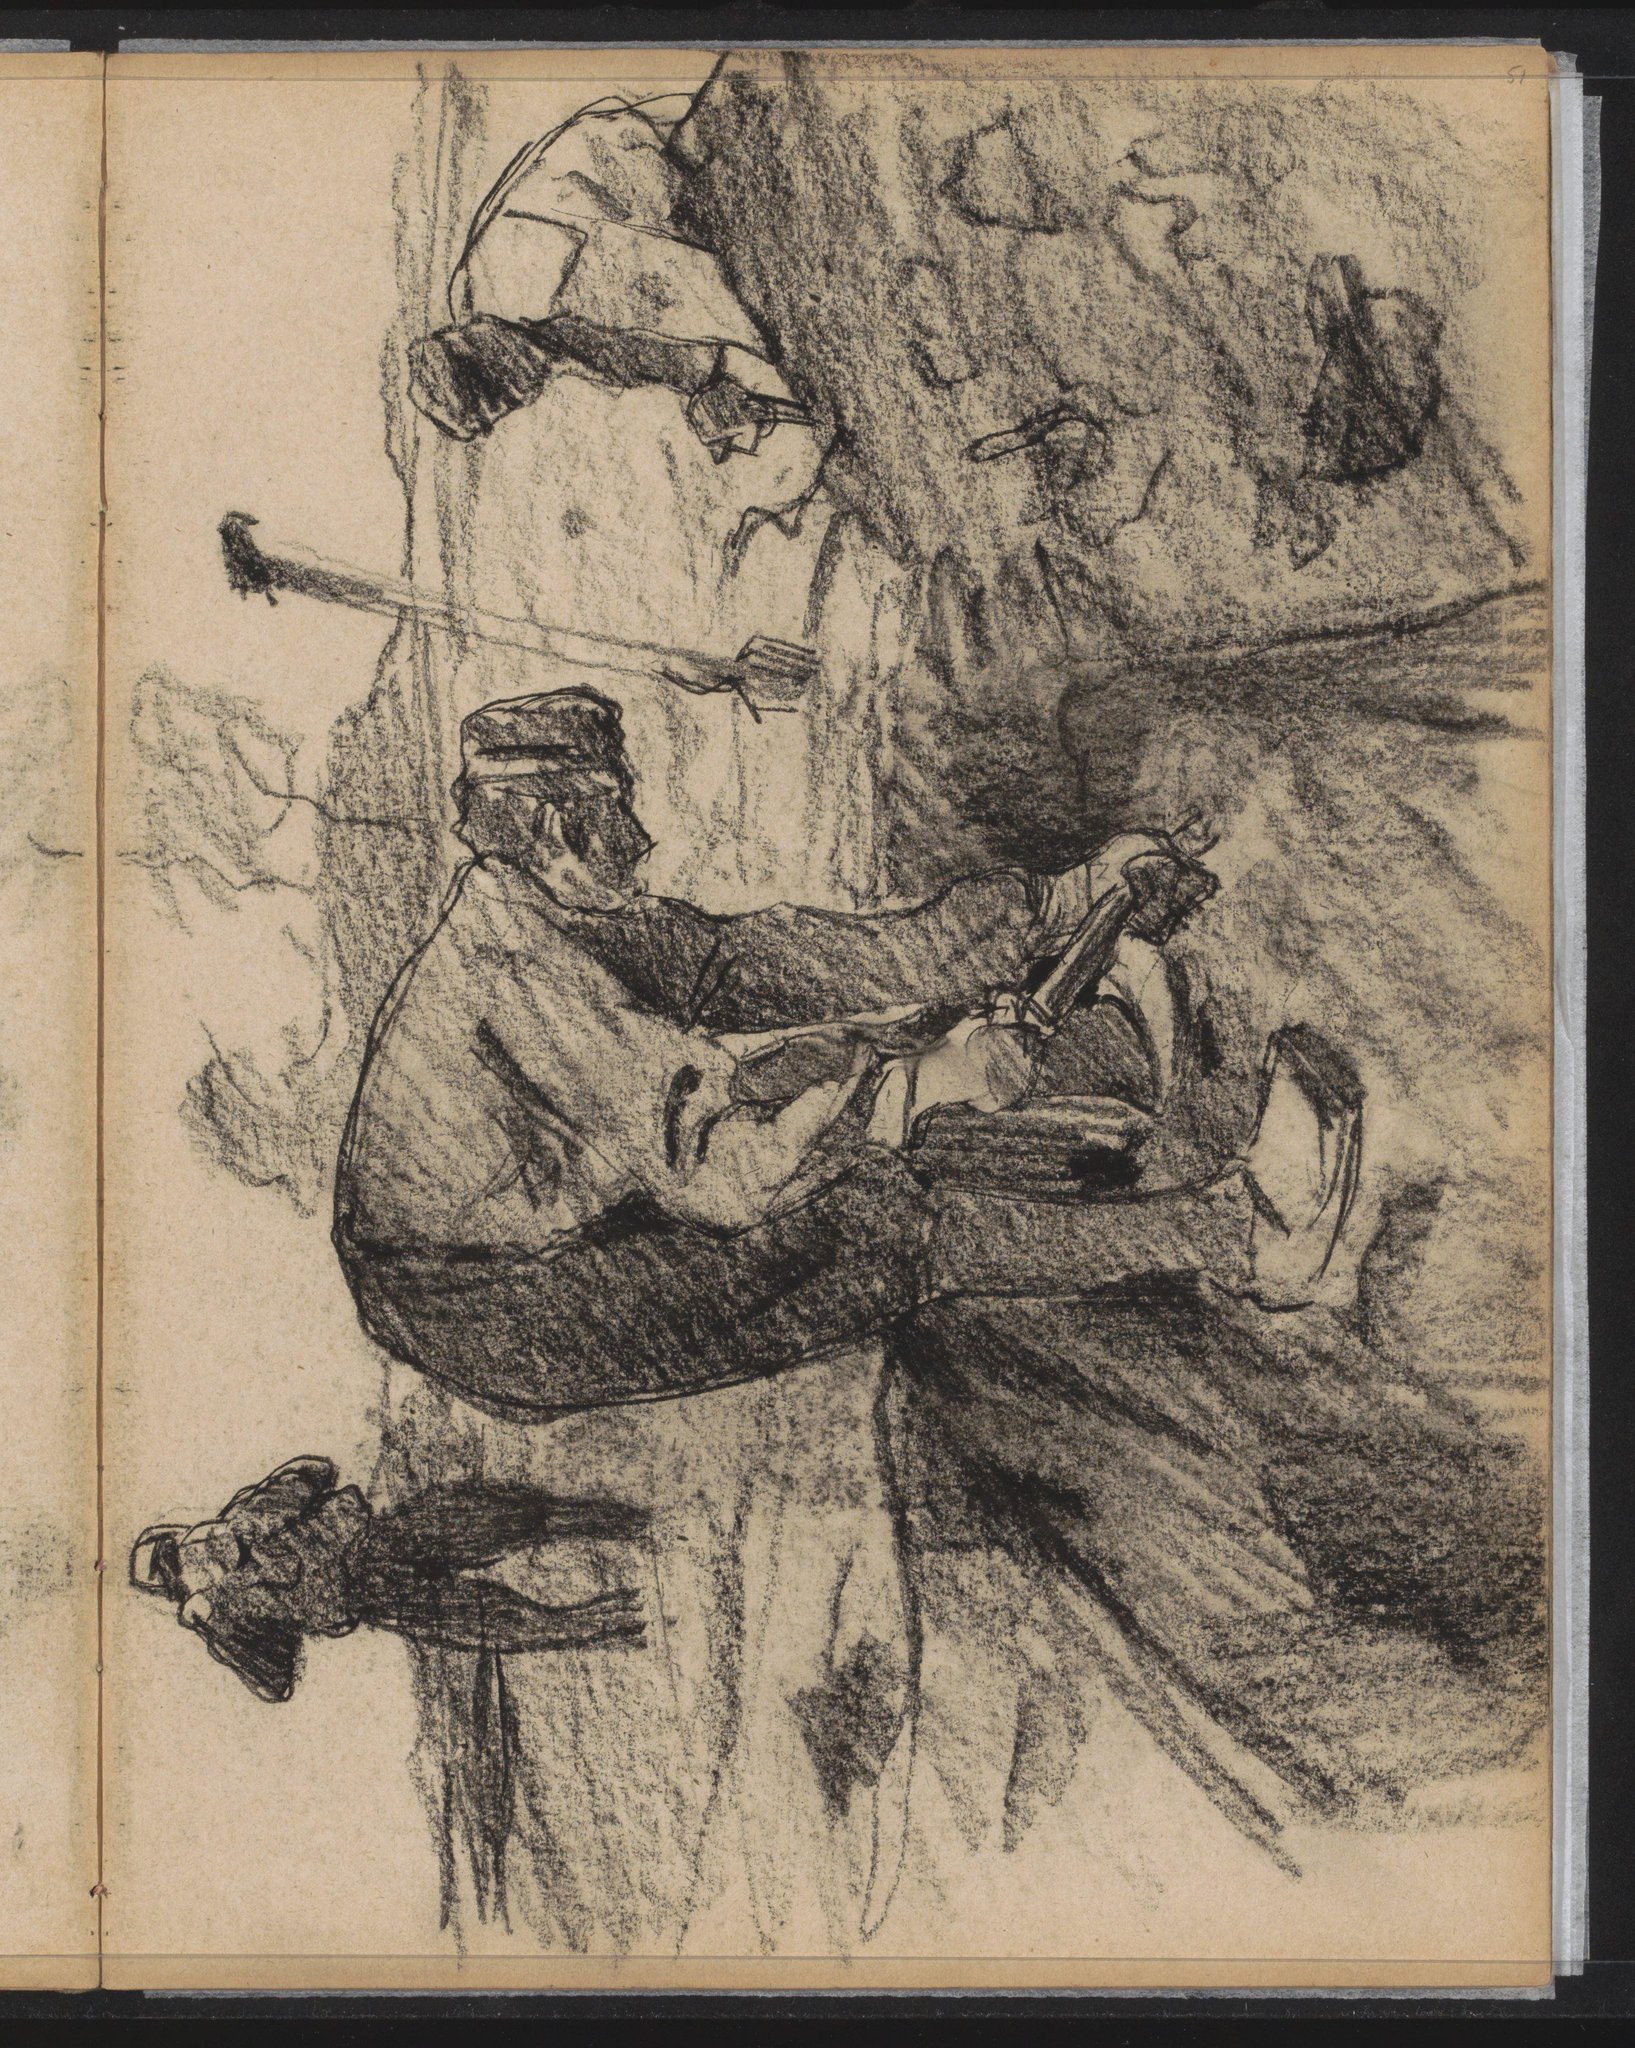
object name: sketchbook leaf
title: Heiwerkers op het land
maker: willem witsen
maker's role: draughtsman, painter, print maker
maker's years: 1860-1923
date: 1884-1887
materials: chalk, paper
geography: ewijkshoeve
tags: building-site (+ men (labourers)), agricultural implements: spade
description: Pagina 51 uit een schetsboek met 49 bladen.